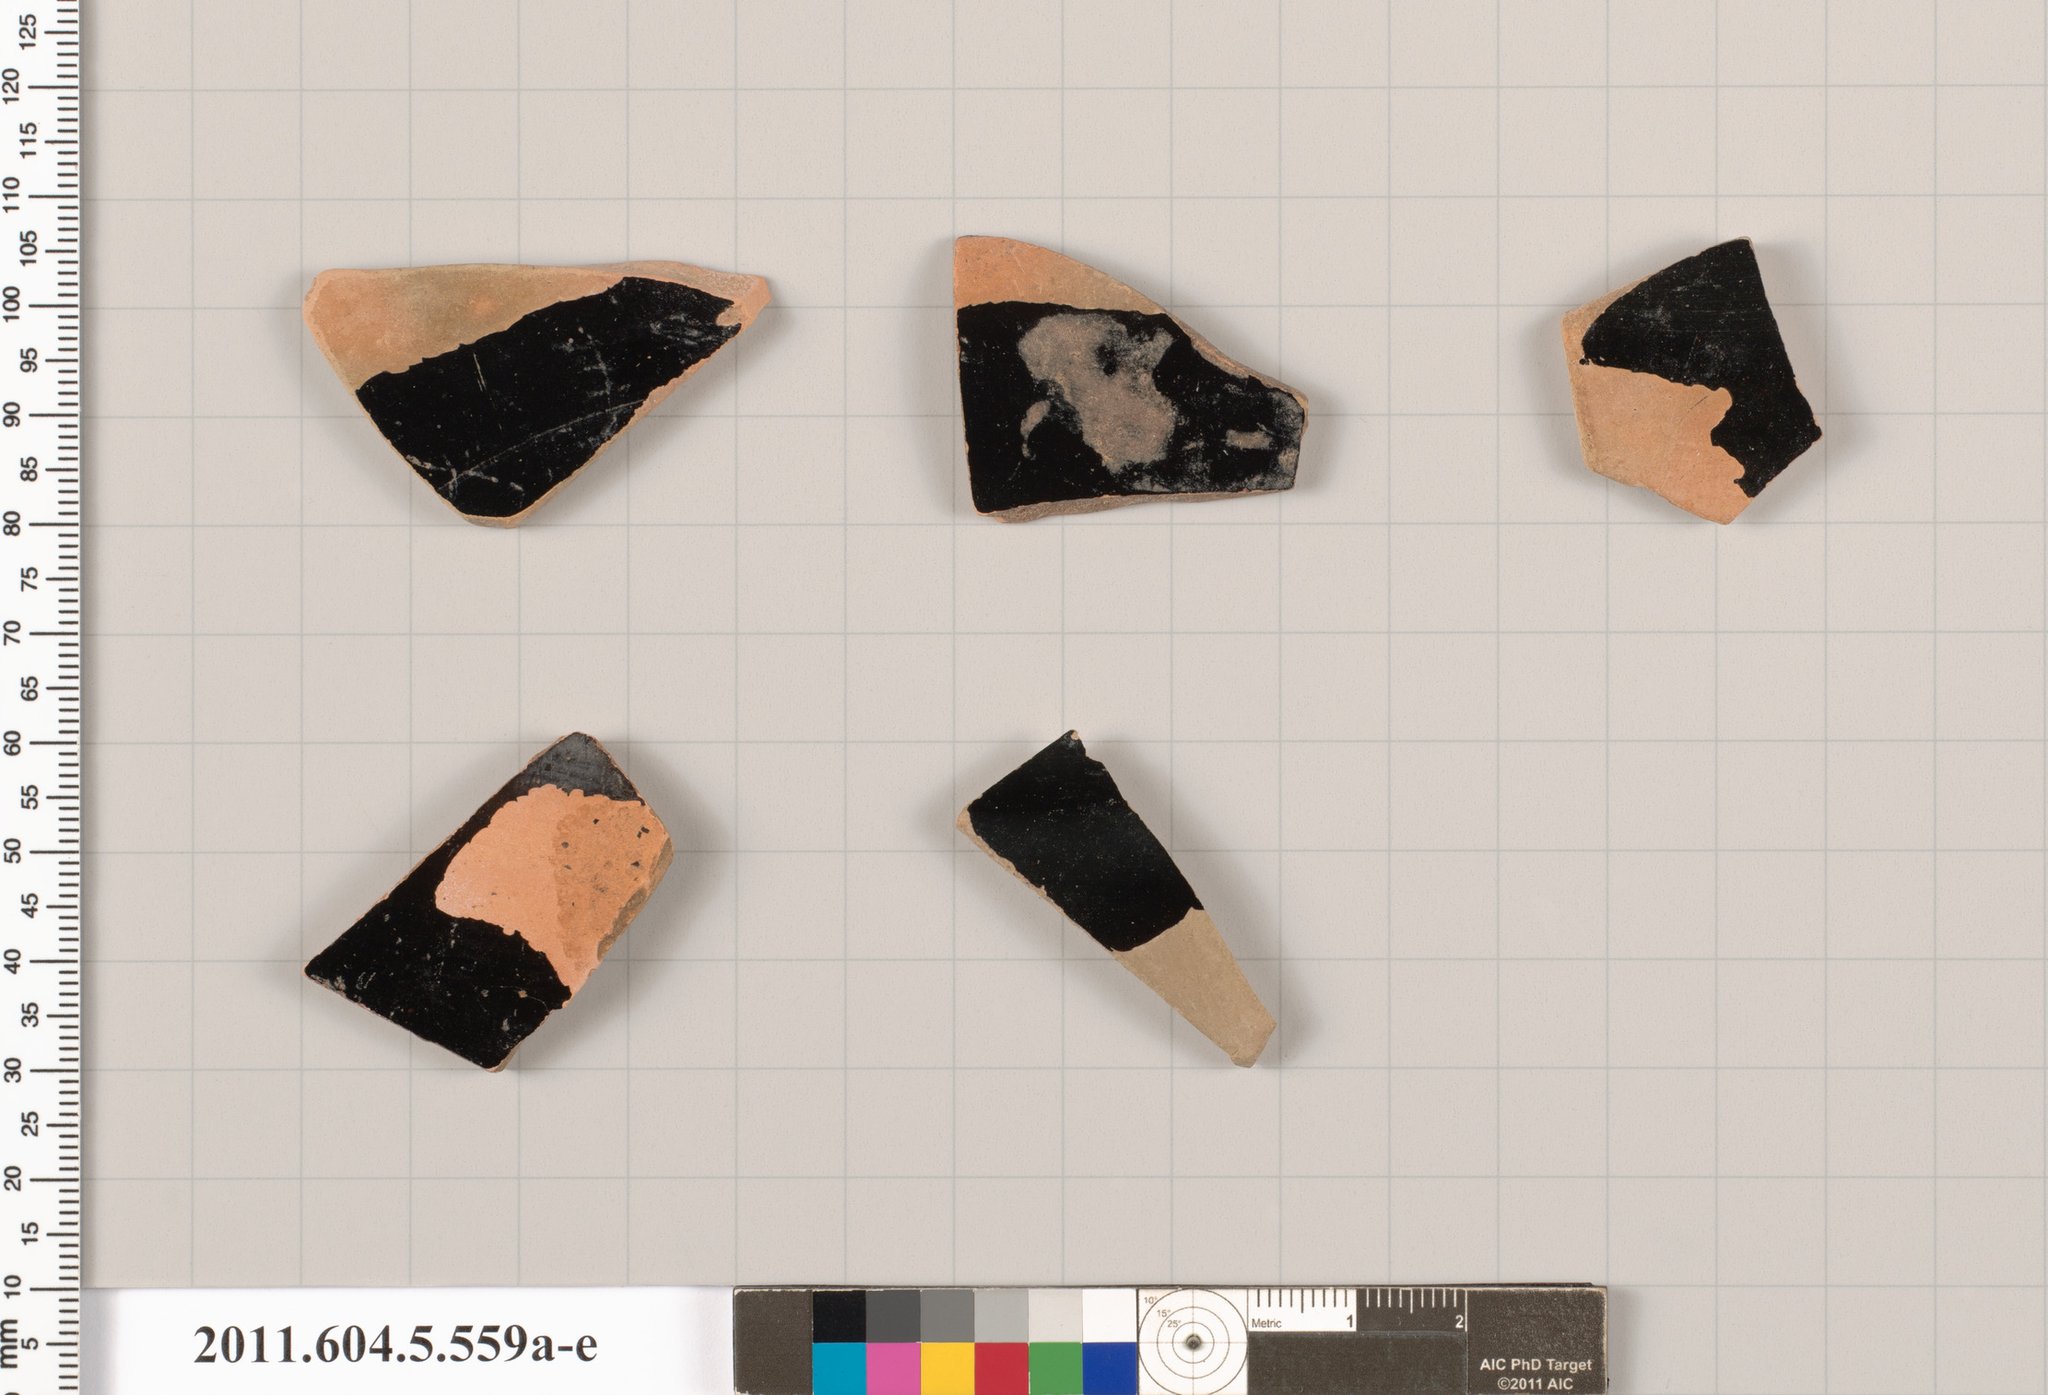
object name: kylix fragment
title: Terracotta fragment of a kylix (drinking cup)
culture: greek, attic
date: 600-401 BCE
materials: terracotta